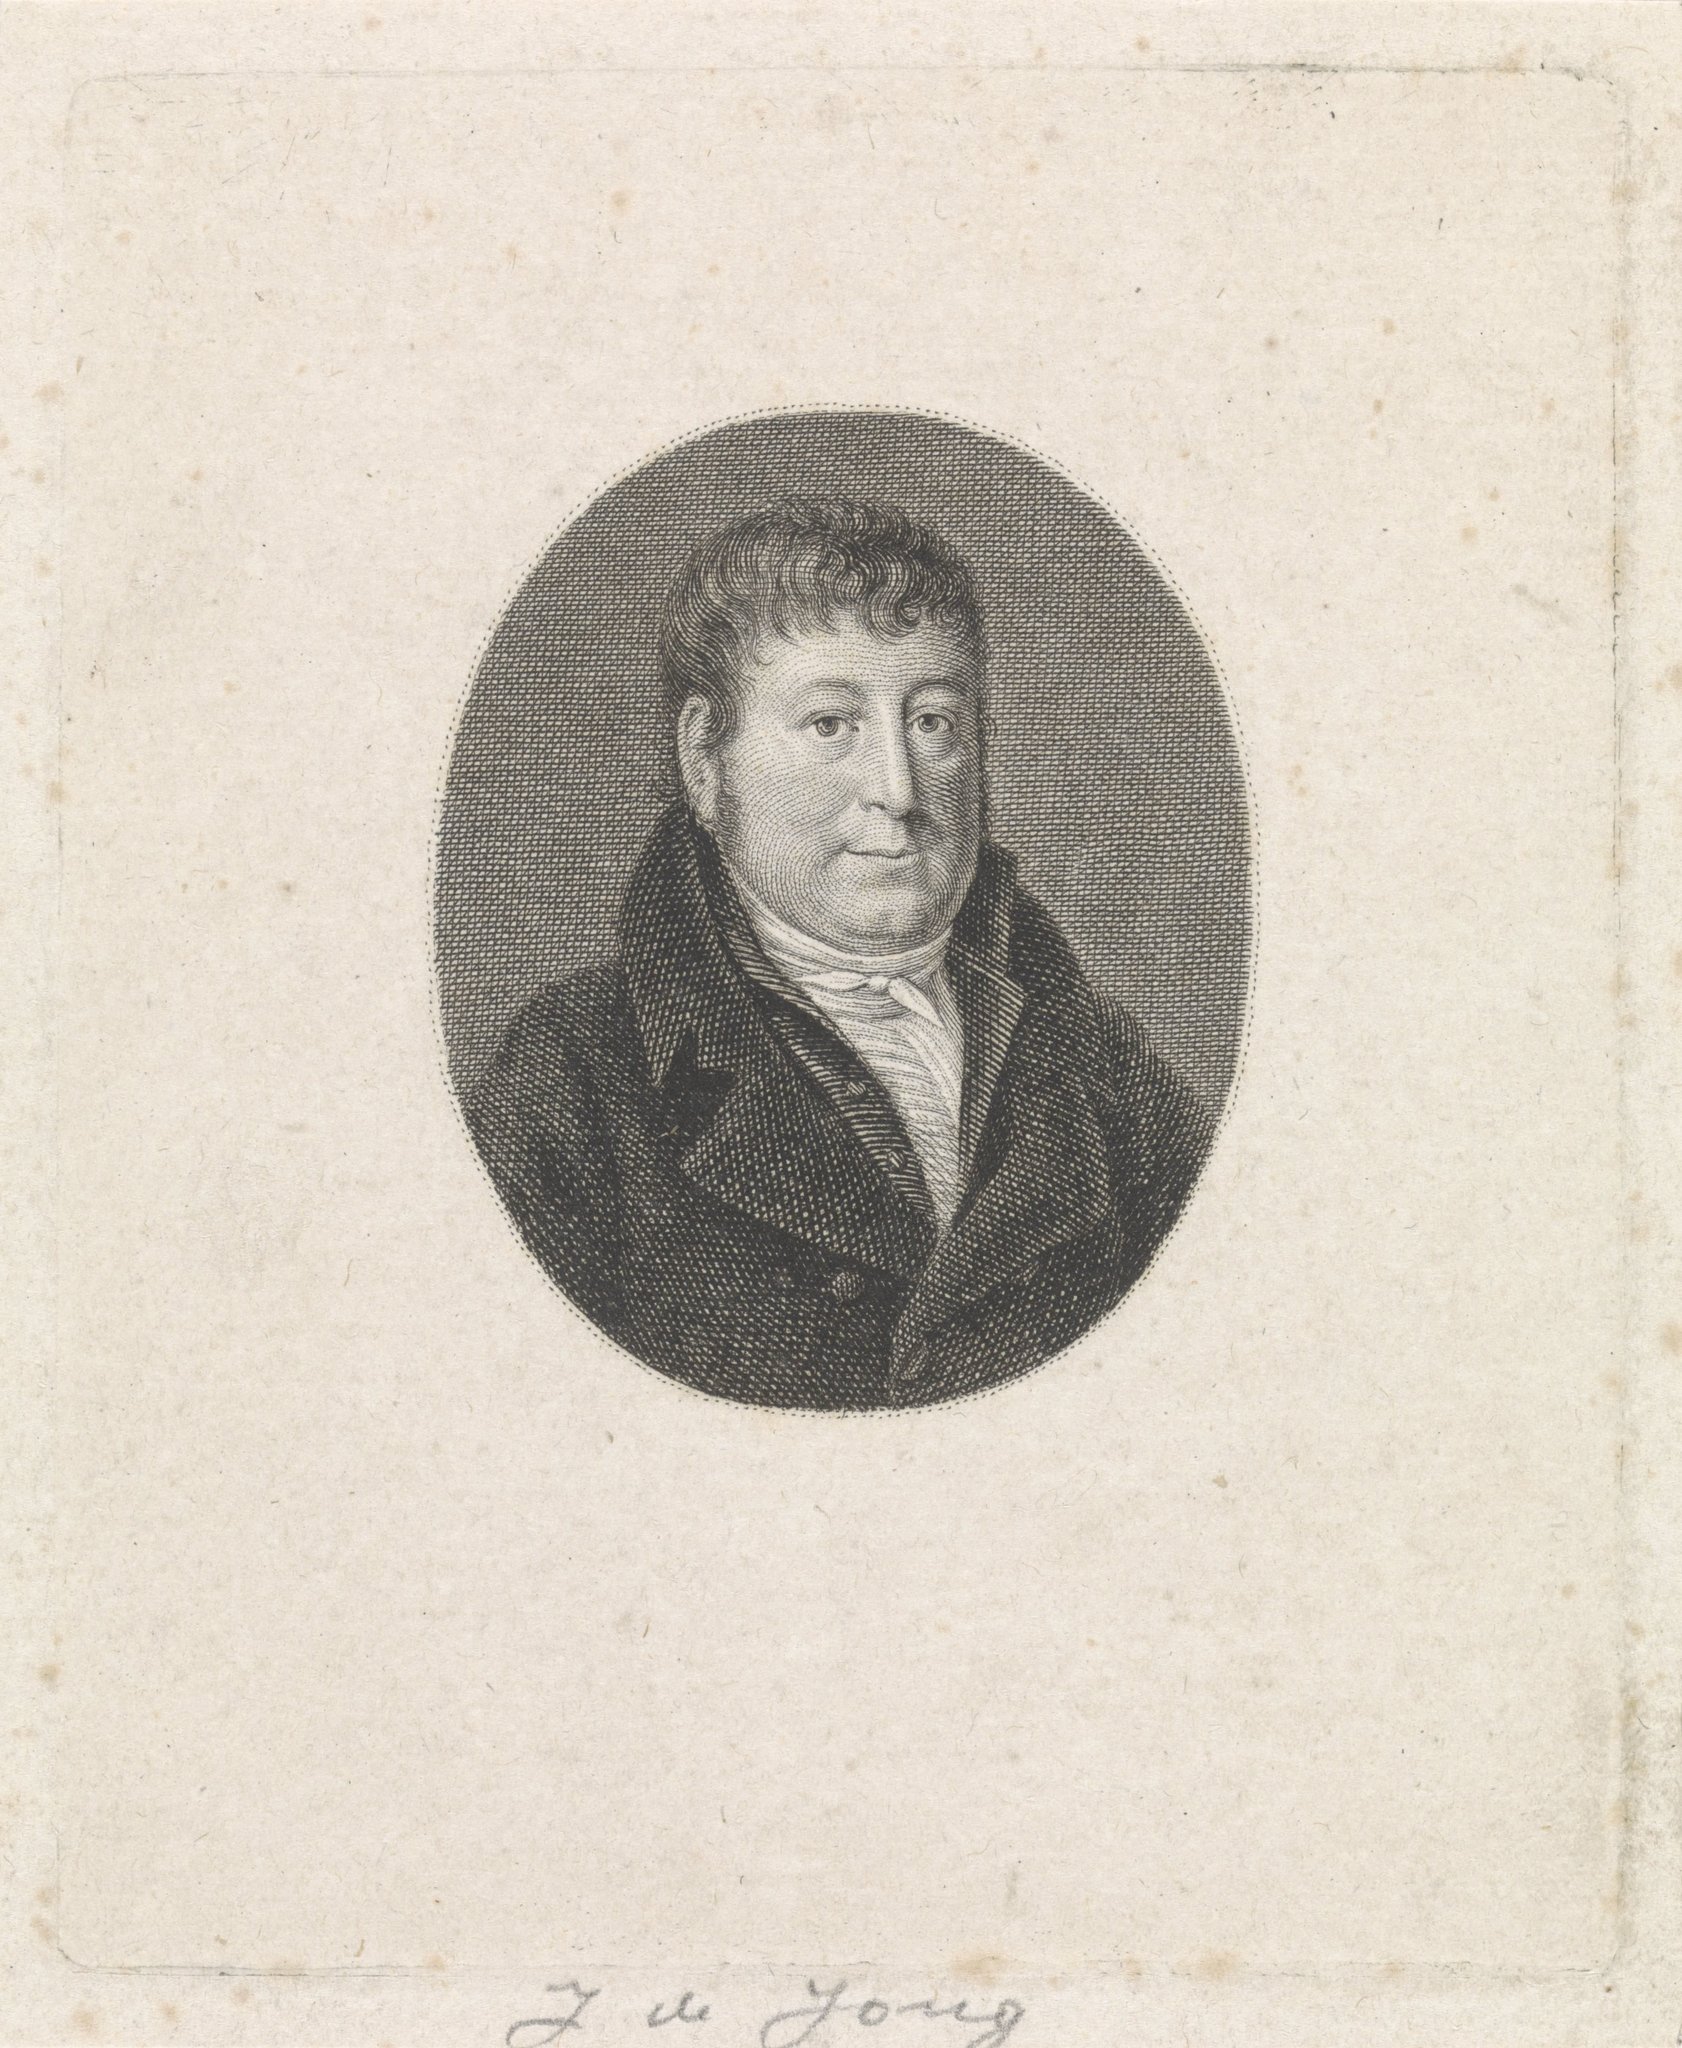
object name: print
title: Portret van J. de Jong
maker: jacob ernst marcus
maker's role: draughtsman, print maker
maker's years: 1774-1826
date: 1784-1826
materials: paper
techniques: etching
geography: amsterdam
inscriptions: collector's mark: Lugt 2228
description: Portret van J. de Jong. Mogelijk een brandassuradeur uit Amsterdam of de schrijver Jacob de Jong.